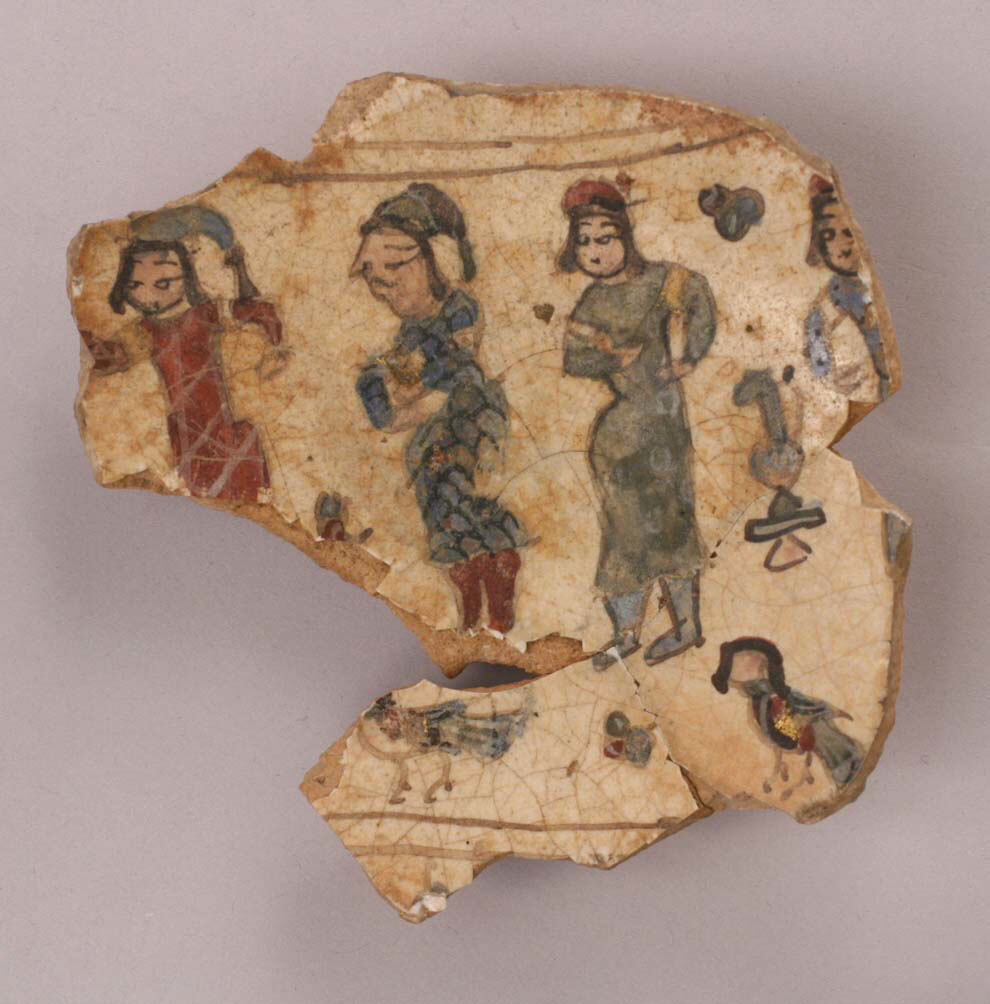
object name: fragment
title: Fragment of a Bowl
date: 1101-1300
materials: stonepaste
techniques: overglaze, painting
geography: iran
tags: human figures,birds